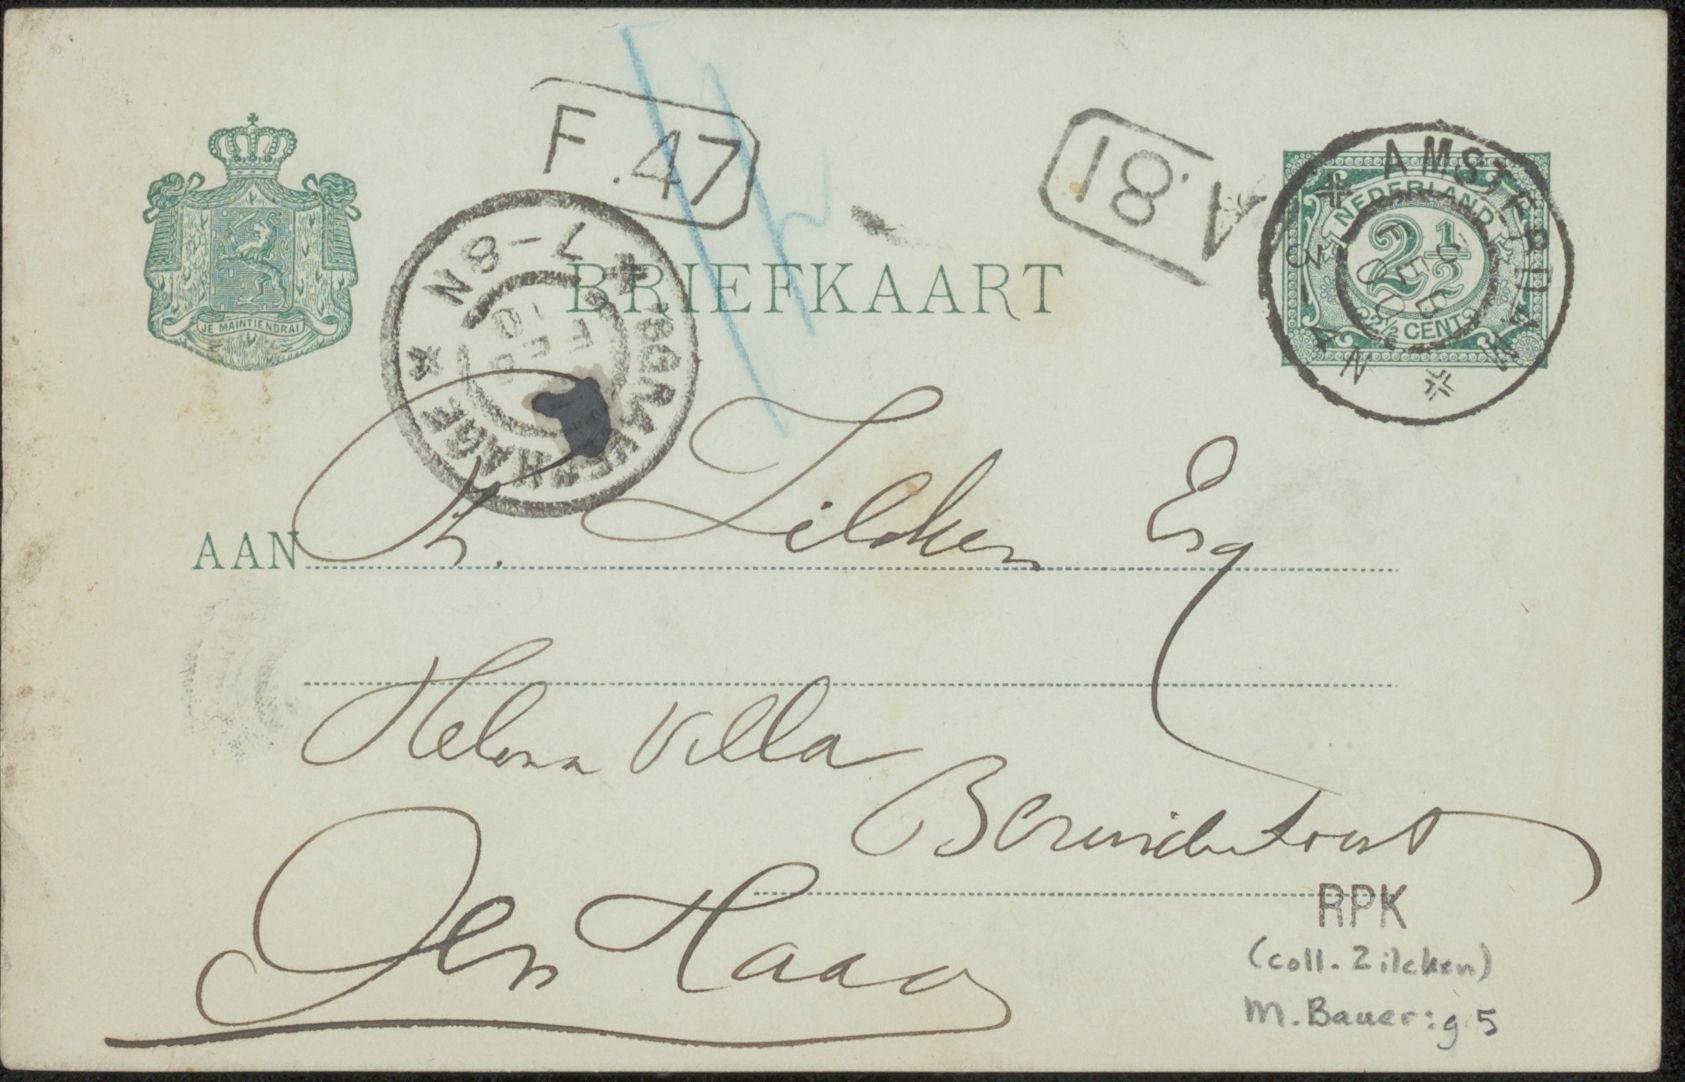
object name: postcard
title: Briefkaart aan Philip Zilcken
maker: marius bauer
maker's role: draughtsman, print maker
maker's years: 1867-1932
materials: cardboard, ink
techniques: pen, writing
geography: amsterdam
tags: painter, philip zilcken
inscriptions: collector's mark: ‘RPK’